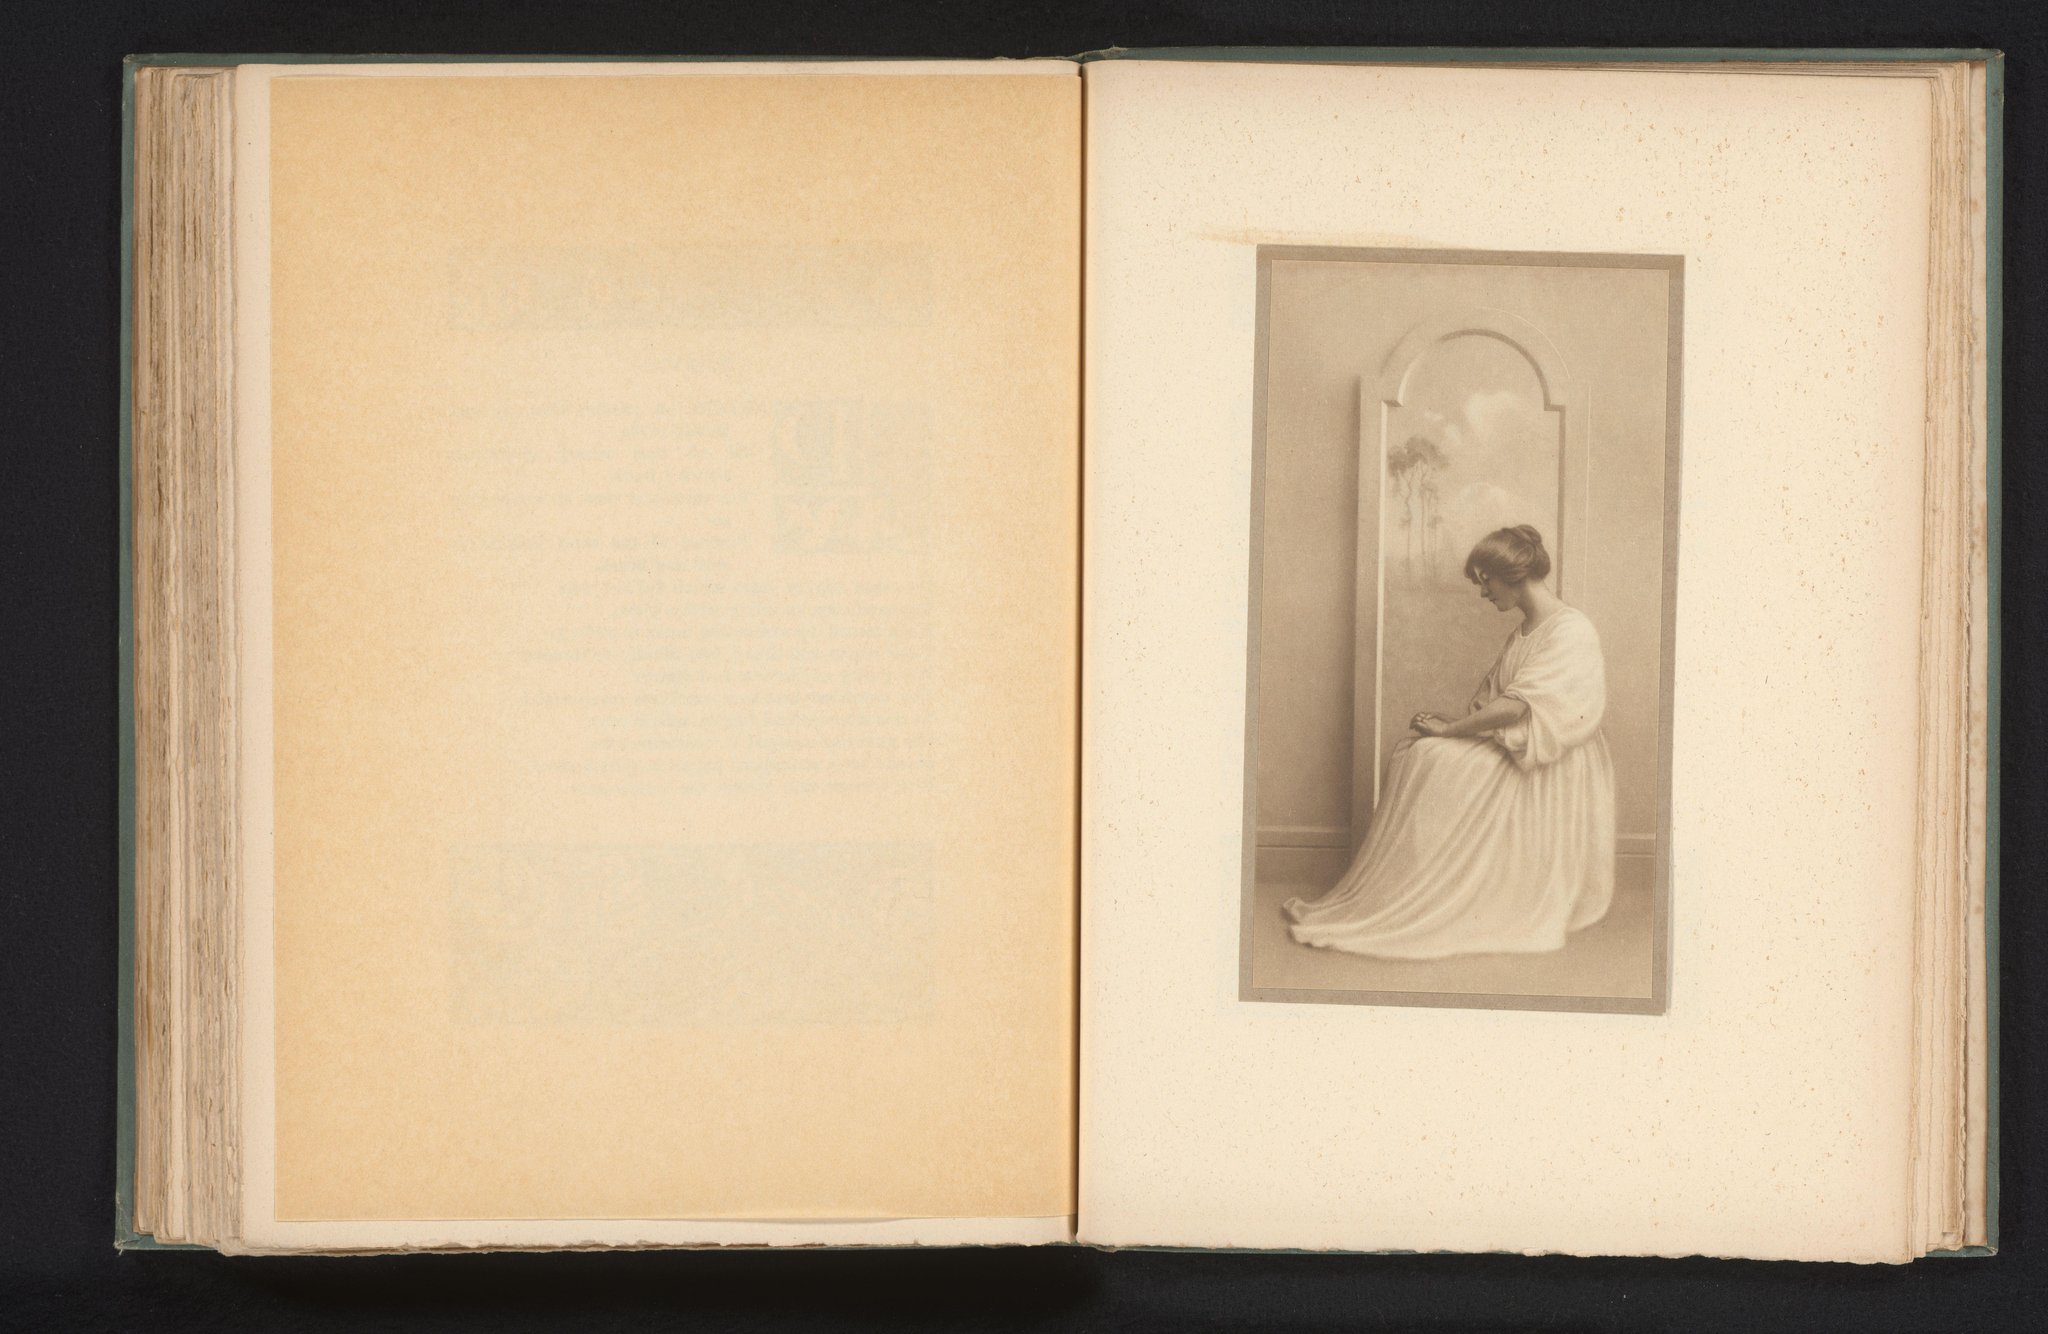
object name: page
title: Vrouw zittend voor een schilderij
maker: adelaide hanscom leeson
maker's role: painter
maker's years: 1875-1931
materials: cardboard, paper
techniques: photoaquatint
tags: adult woman, picture, painting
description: Prent op ongenummerde pagina. Adelaide Hanscom Leeson manipuleerde haar glasnegatieven om een schilderachtig efffect te bewerkstelligen.